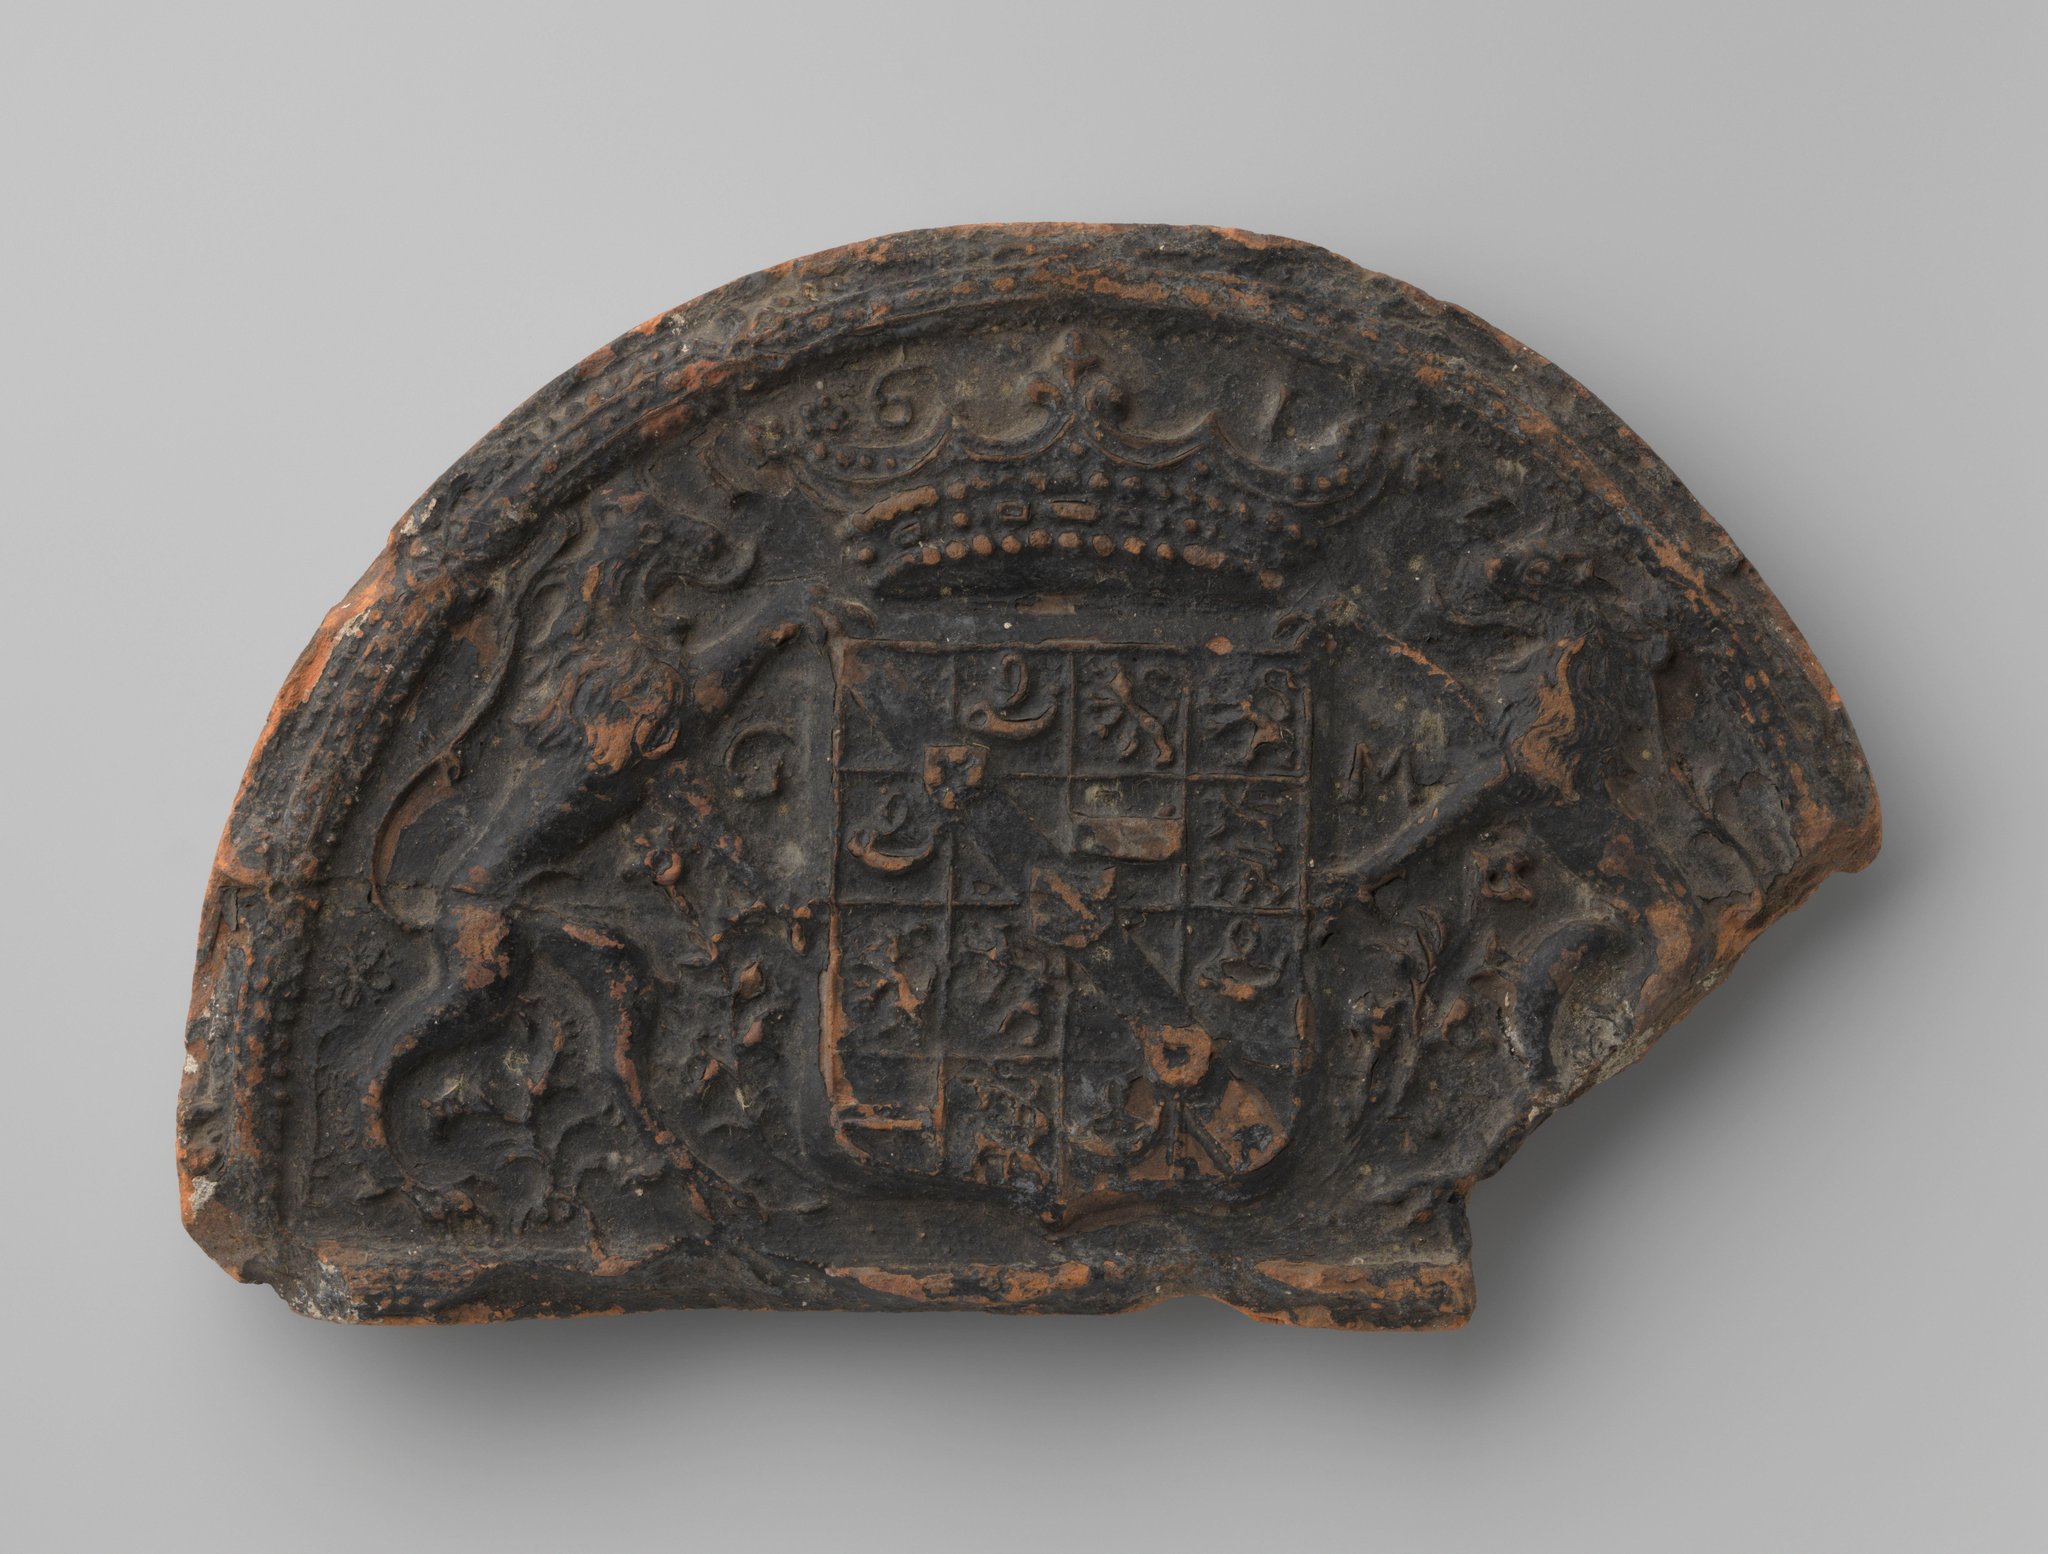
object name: haarddeksteen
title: Haarddeksteen met het wapen van Prins Maurits van Oranje Nassau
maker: Anonymous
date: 1567-1625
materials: earthenware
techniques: printing, firing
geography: netherlands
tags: the hague, maurice (prince of orange)